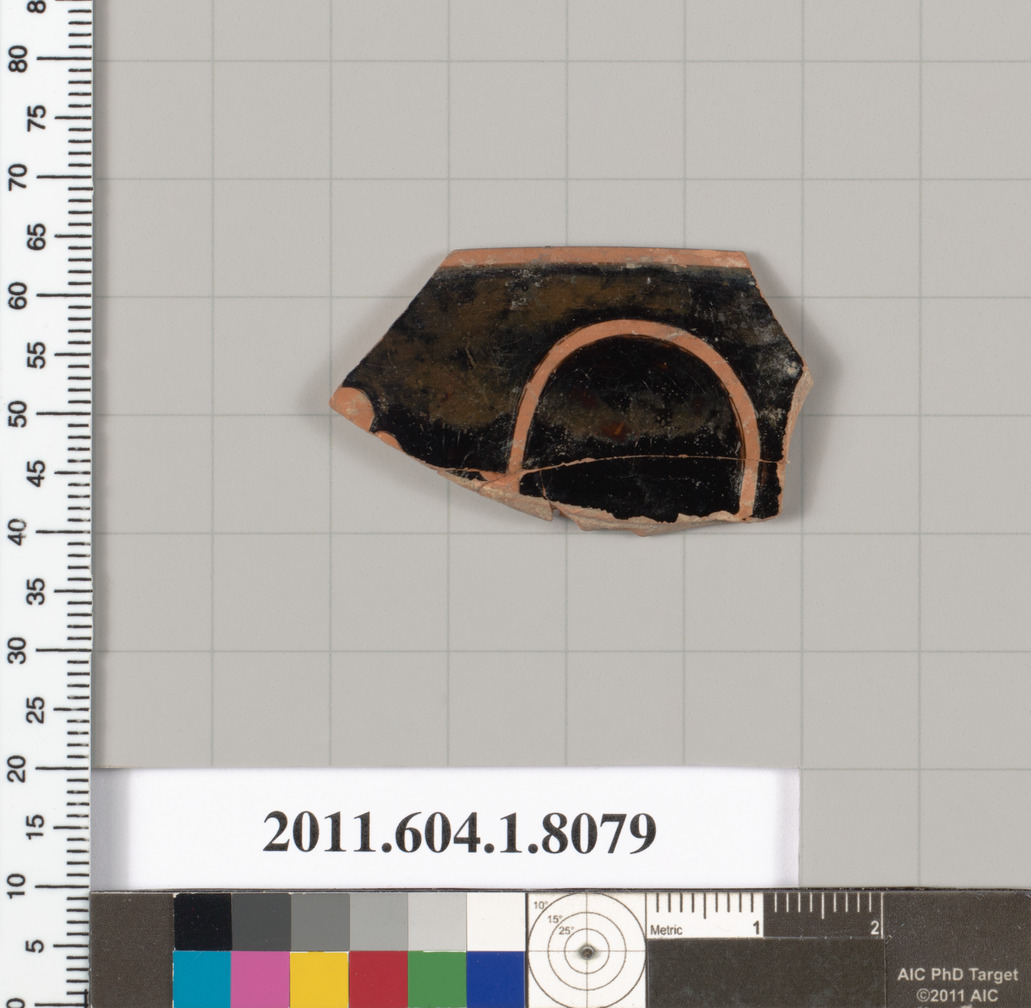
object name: kylix fragment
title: Terracotta rim fragment of a kylix (drinking cup)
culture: greek, attic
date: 510-500 BCE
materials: terracotta